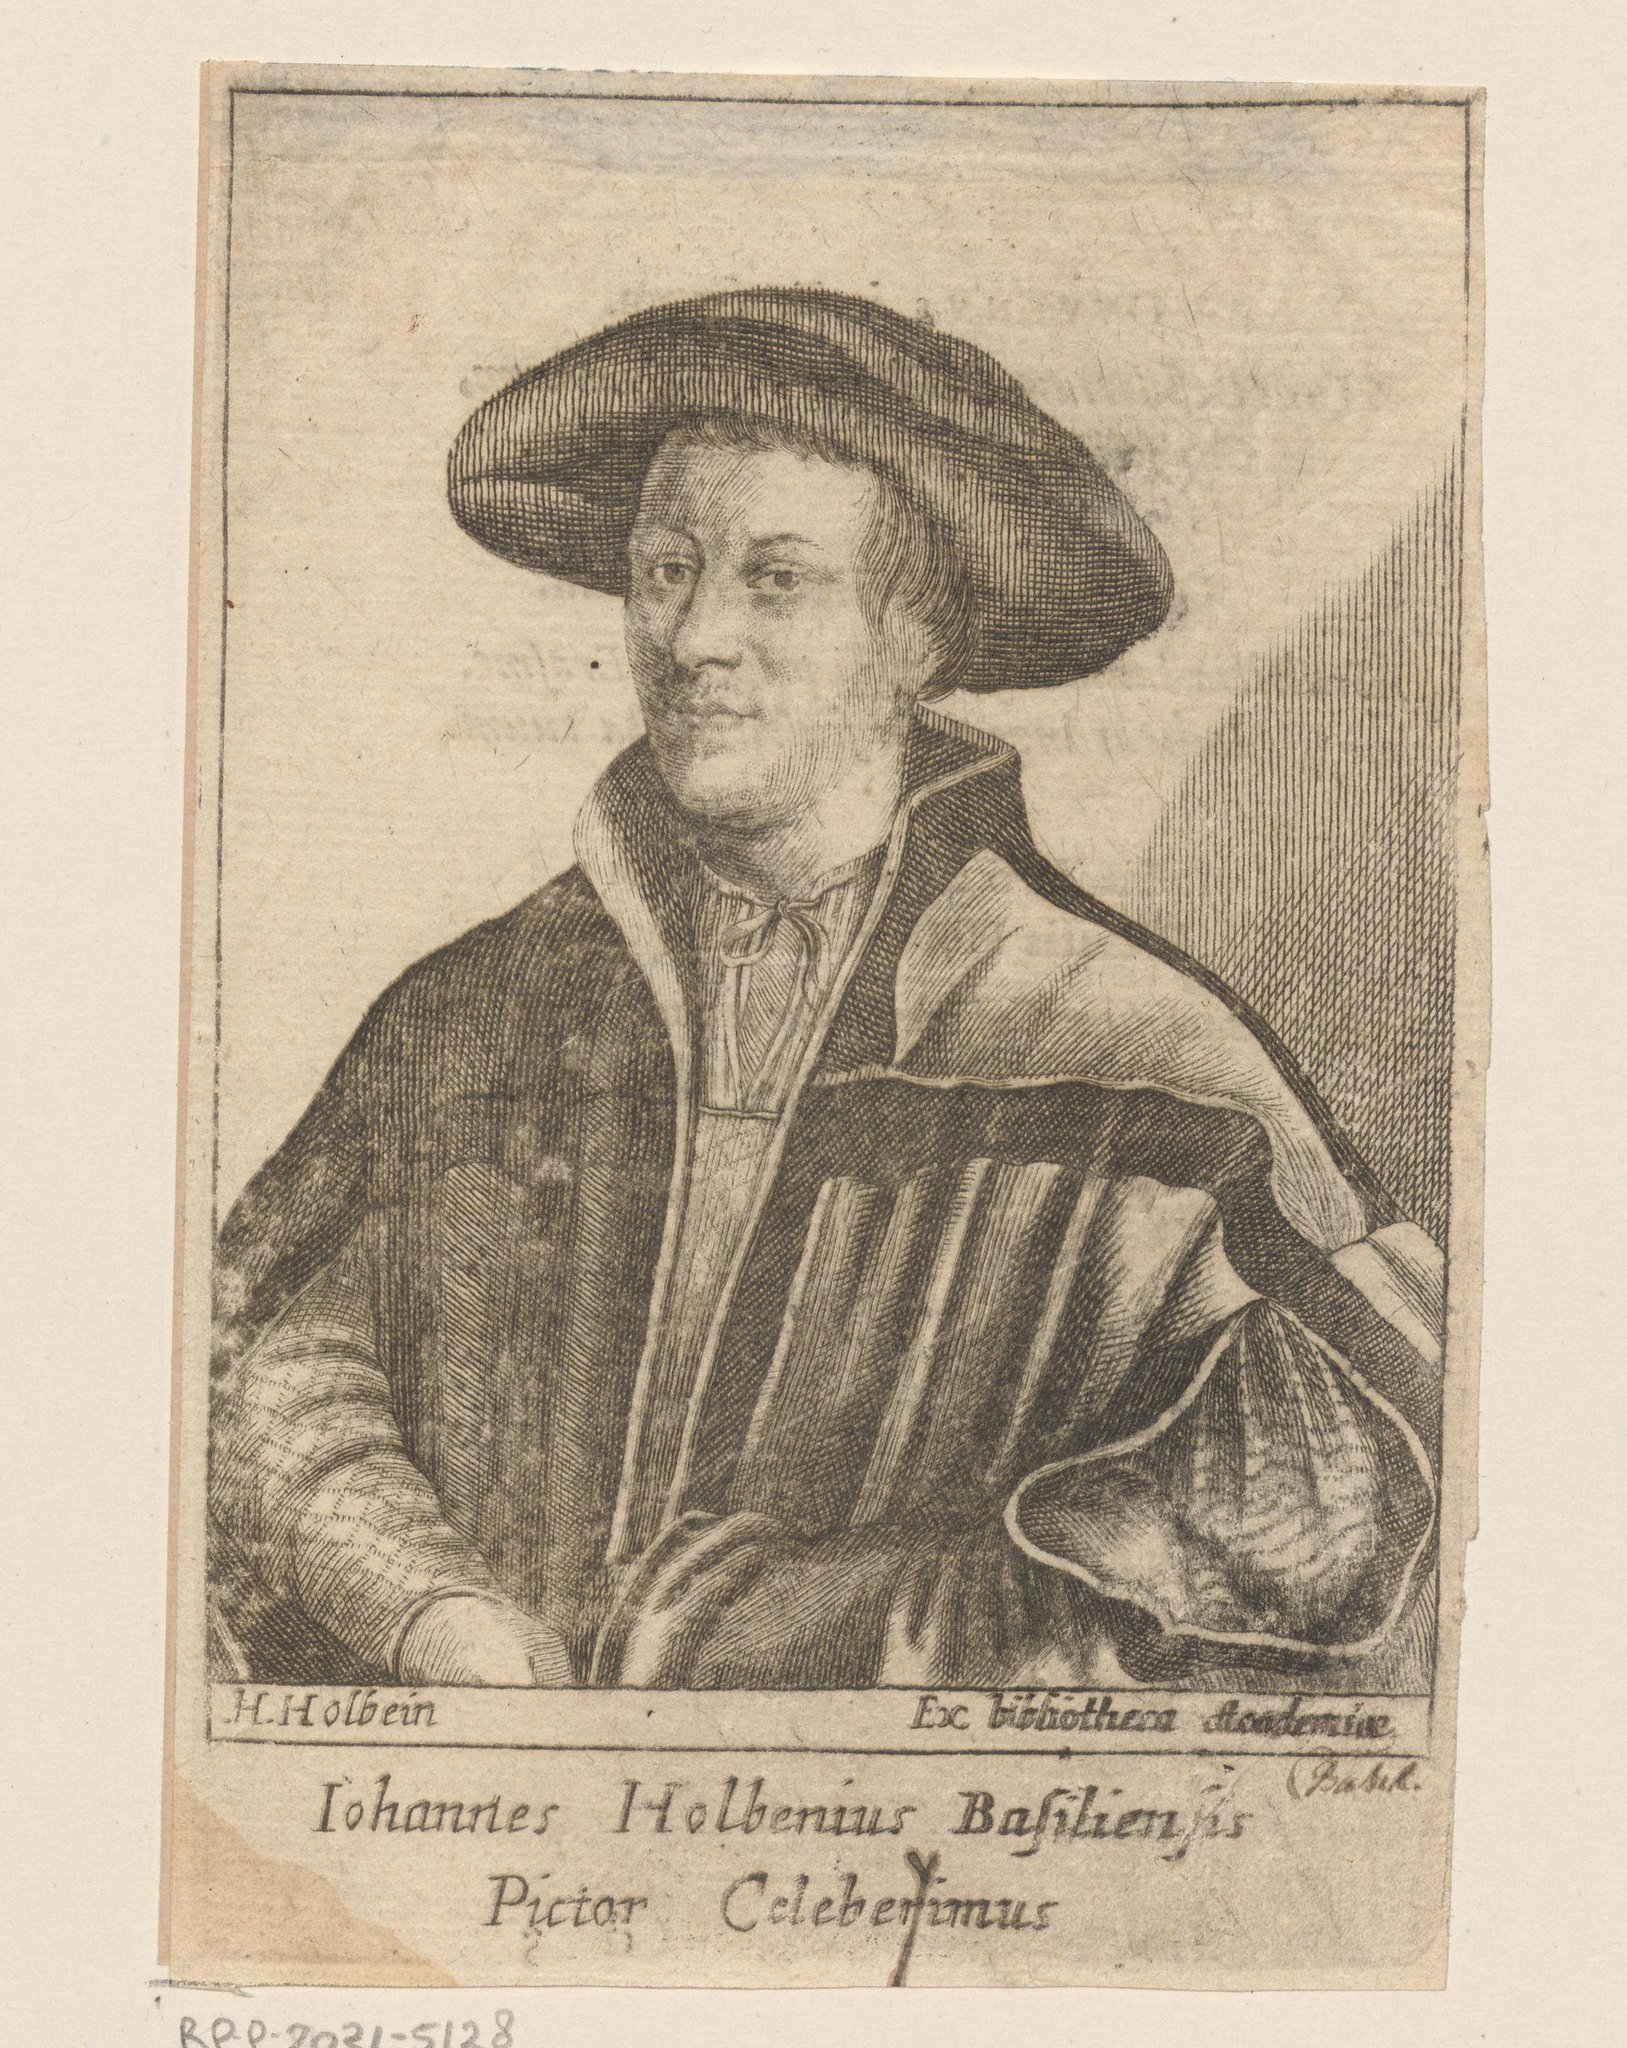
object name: print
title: Portret van Hans Holbein II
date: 1676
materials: paper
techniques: engraving, letterpress printing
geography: basel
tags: augsburg, london, painter, draughtsman, hans holbein (ii), head-gear, historical persons, portrait, self-portrait of painter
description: Prent uit: Erasmus, Desiderius. Morias enkomion; Stultitiae laus. Des. Erasmi Rot. declamatio, cum commentariis Ger. Listrii. Basel: Genathianis, 1676.